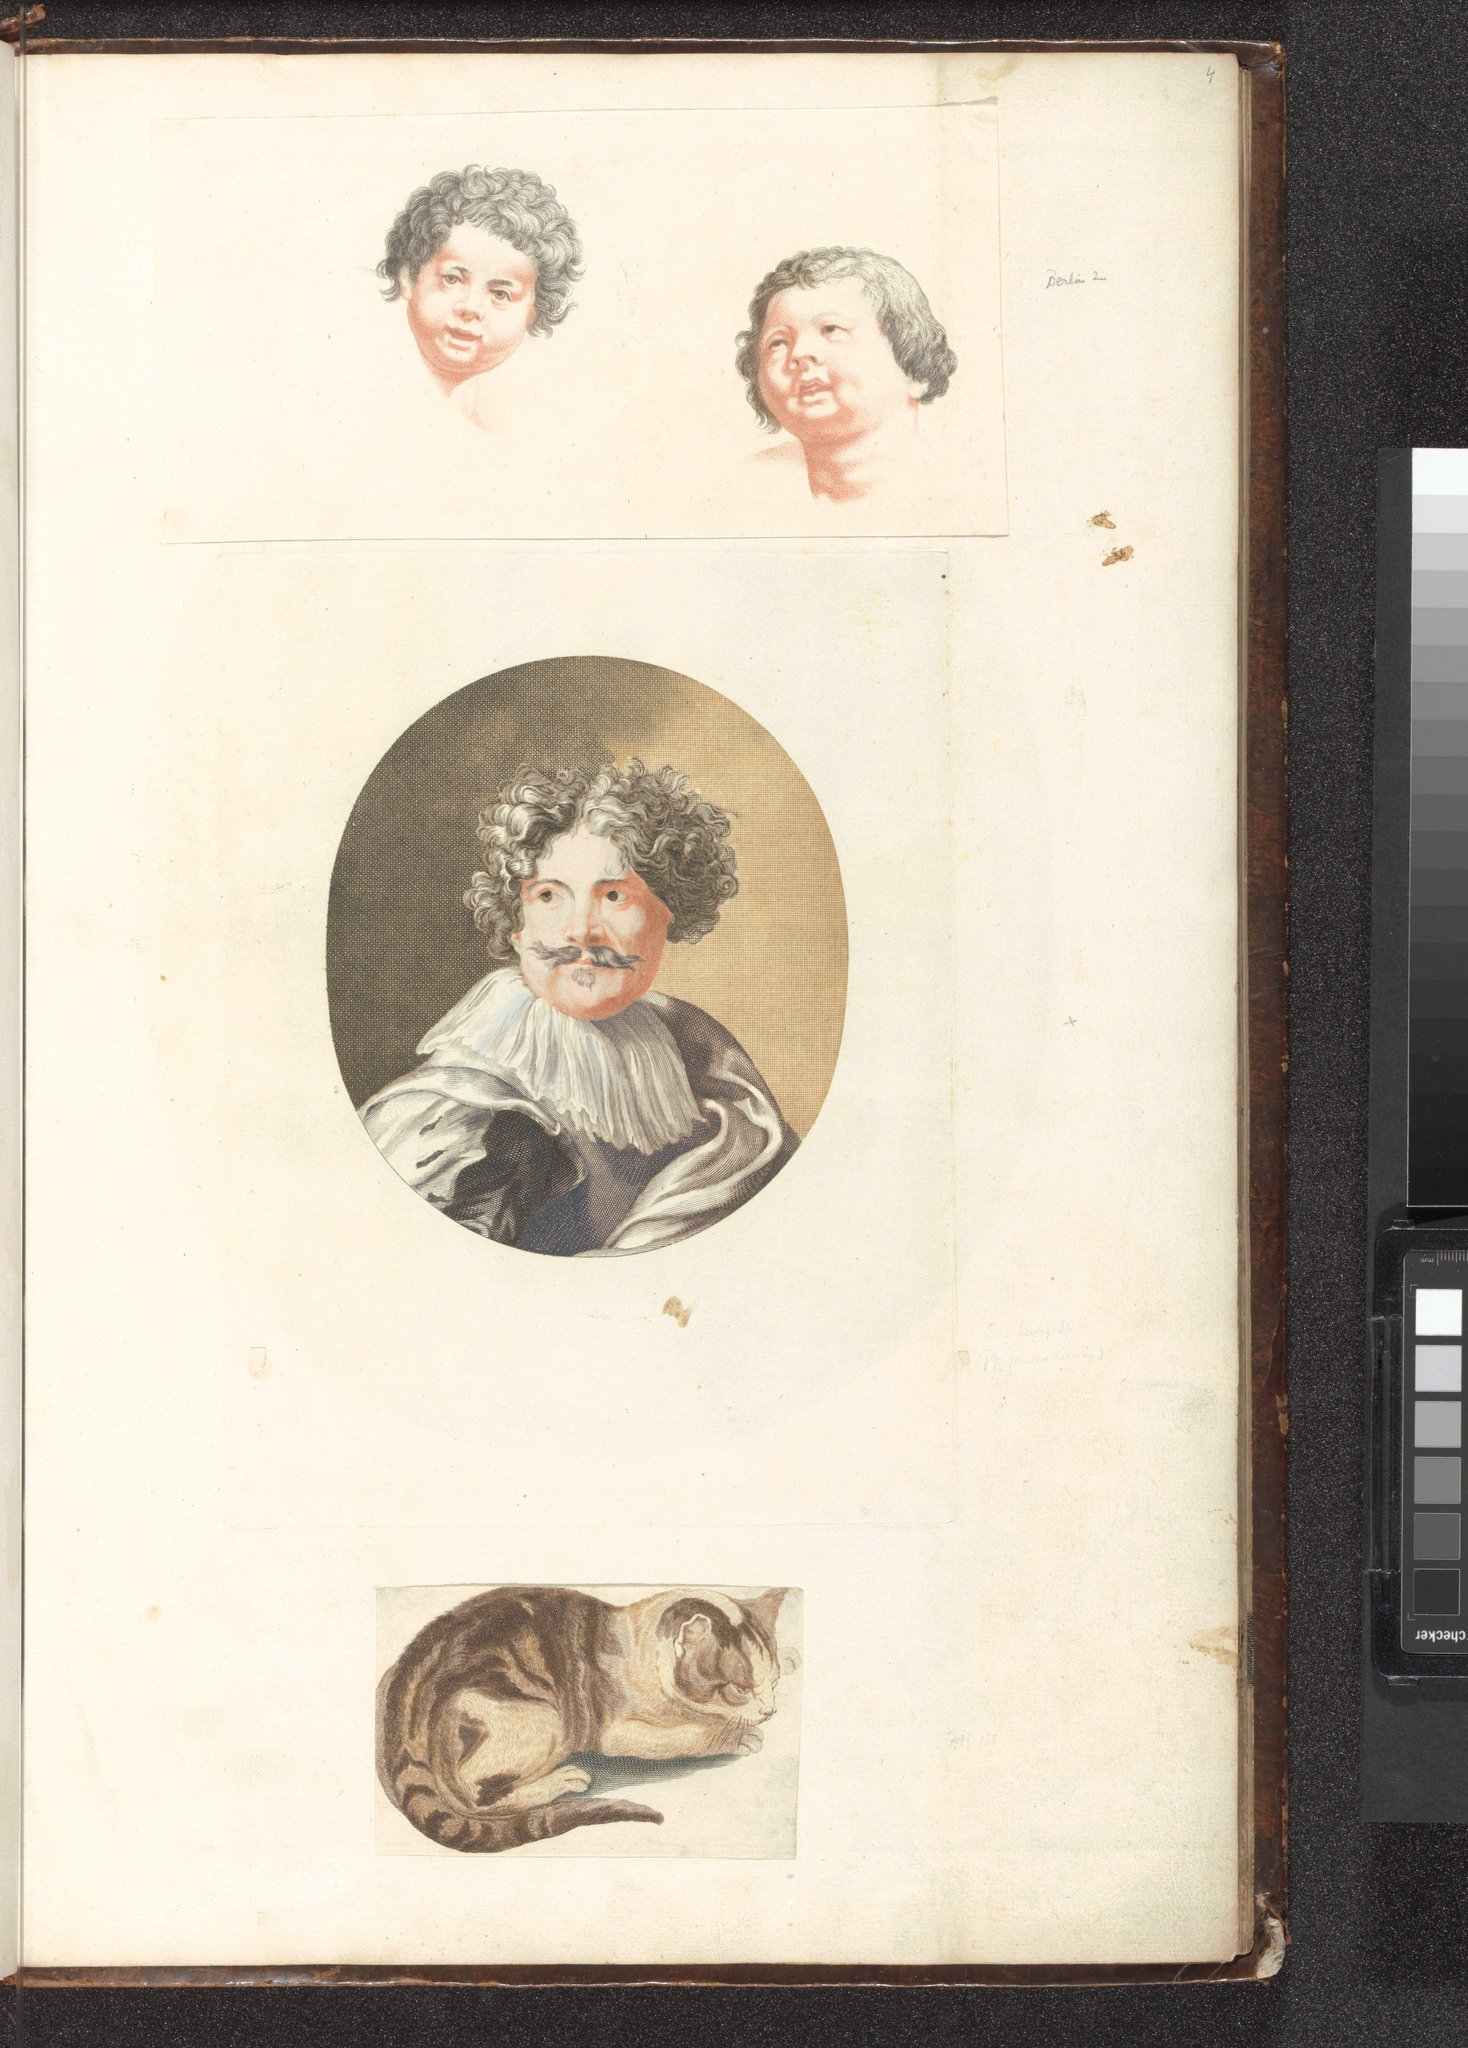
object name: album leaf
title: Kat naar rechts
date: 1688-1698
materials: paper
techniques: printing, engraving, lithography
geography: netherlands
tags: cat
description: Liggende kat naar rechts. Deze prent maakt deel uit van een album.